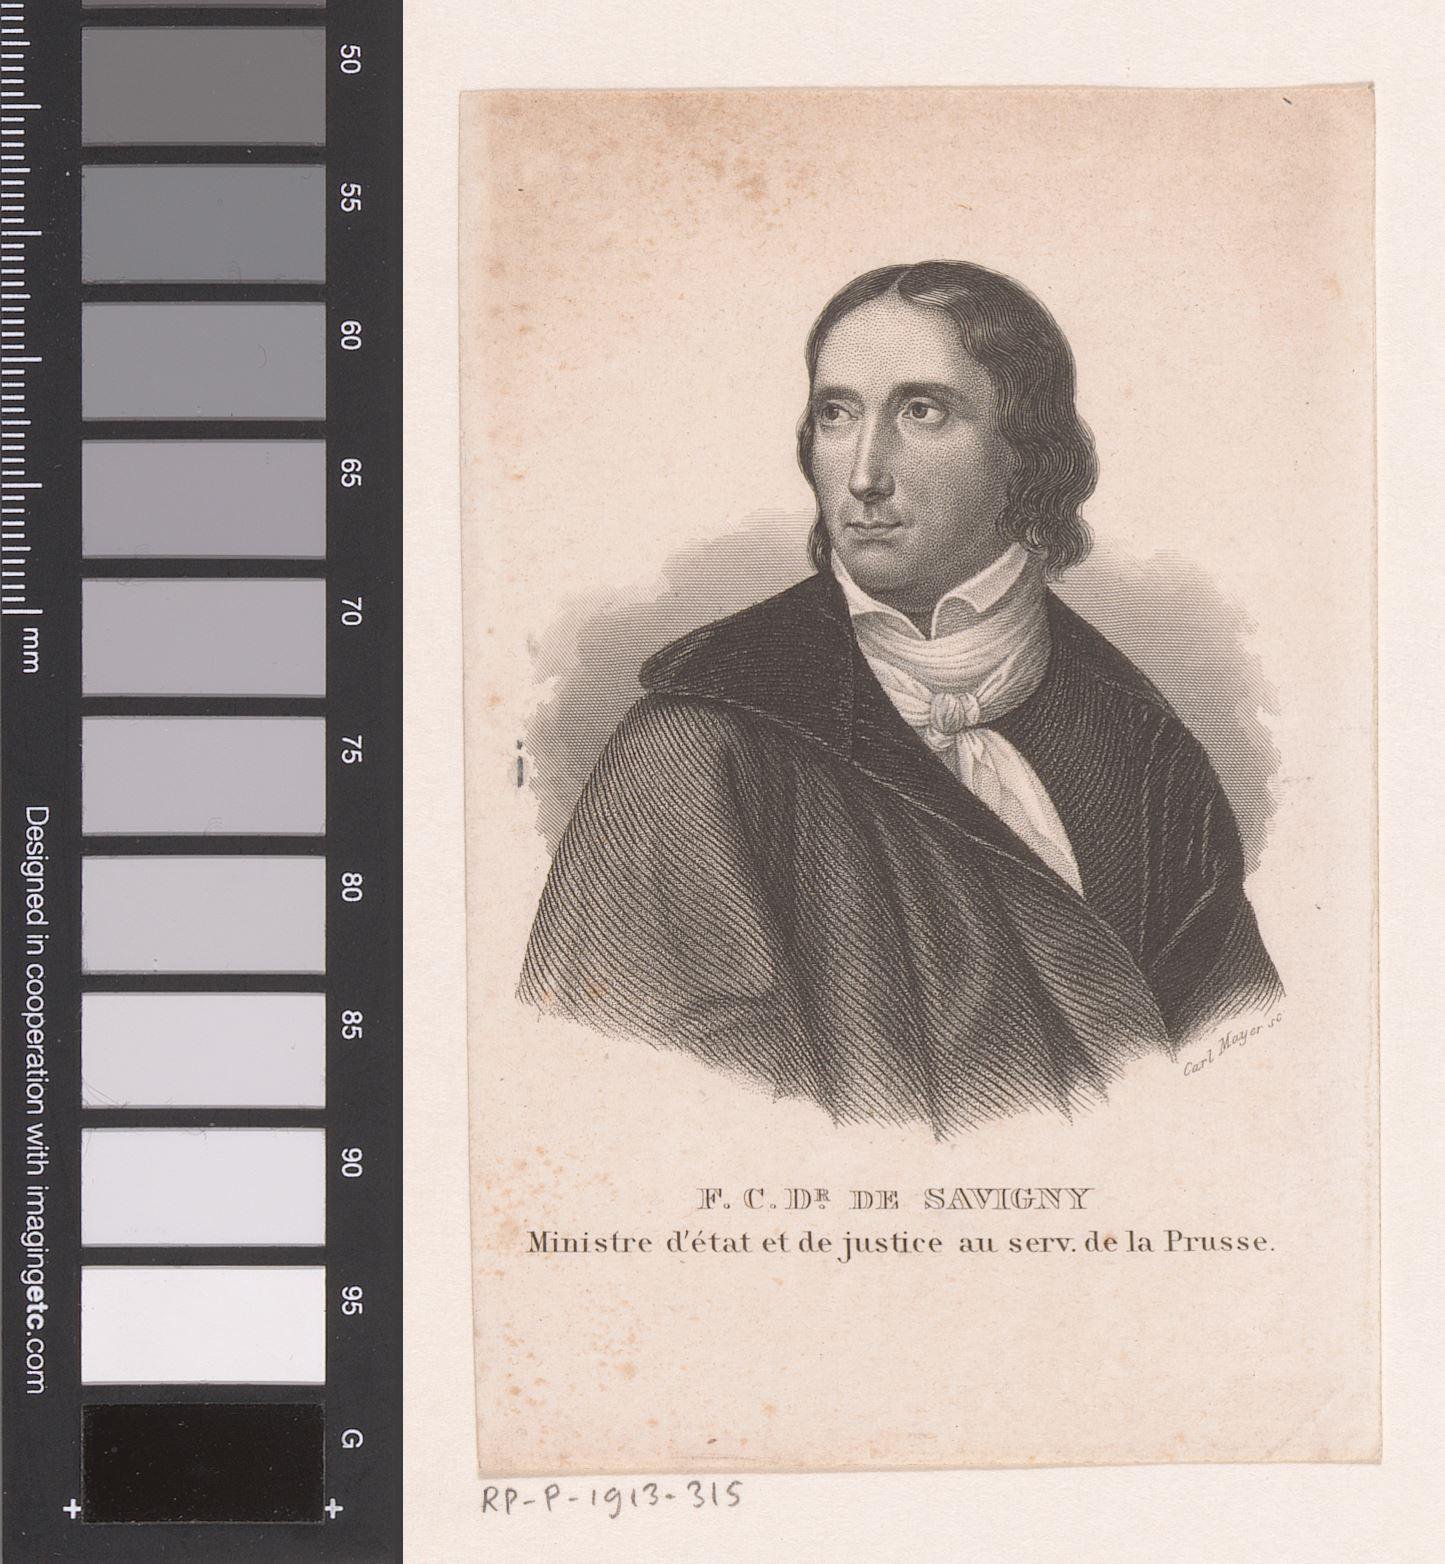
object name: print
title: Portret van Friedrich Carl von Savigny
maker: carl mayer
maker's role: print maker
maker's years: 1798-1868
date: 1842-1868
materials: paper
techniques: engraving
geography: nuremberg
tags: berlin, historical persons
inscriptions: collector's mark: Lugt 2228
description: Prent mogelijk afkomstig uit de Almanach de Gotha.